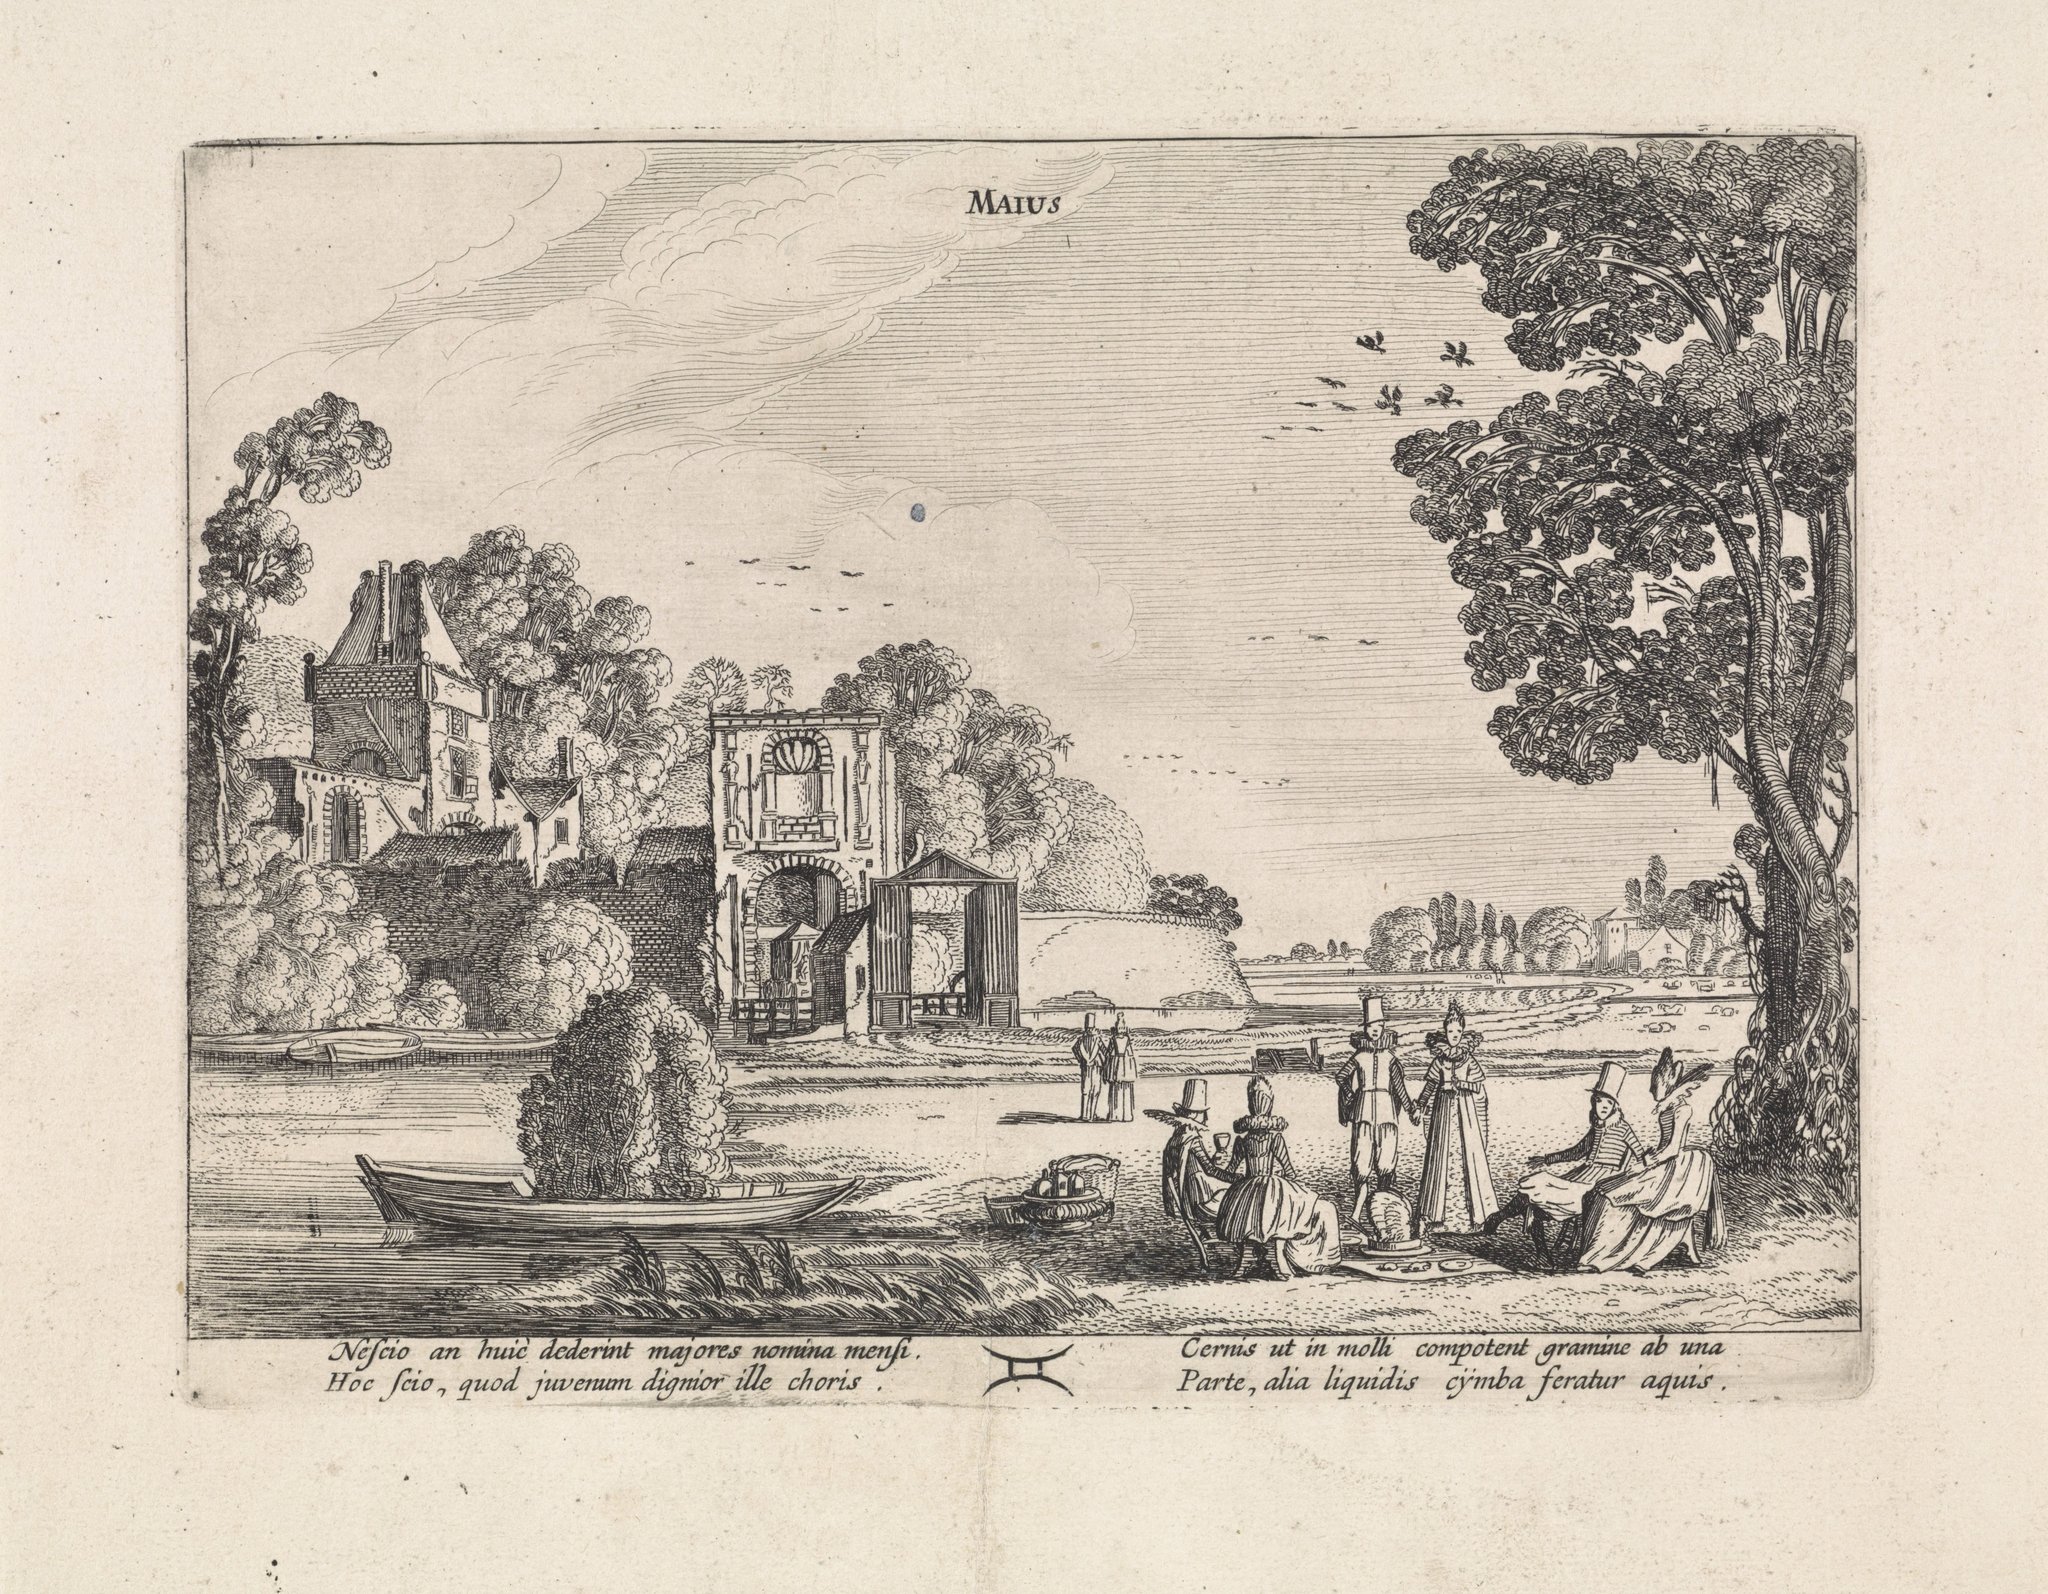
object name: print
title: Maius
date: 1608-1618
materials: paper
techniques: etching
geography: northern netherlands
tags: landscape symbolizing may, picnic, alfresco, 'déjeuner sur l'herbe', gemini (zodiacal sign of may), city-gate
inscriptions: collector's mark: Lugt 964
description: Gezicht op de Zijlpoort in Haarlem, waarvoor op een meer een plezierboot is aangemeerd, voorstellende de maand mei. Rechts op de voorgrond een elegant gezelschap dat aan het picknicken is. In het midden een wandelend paar. Onderaan het astrologische symbool van het sterrenbeeld tweelingen. Prent uit een serie van twaalf.